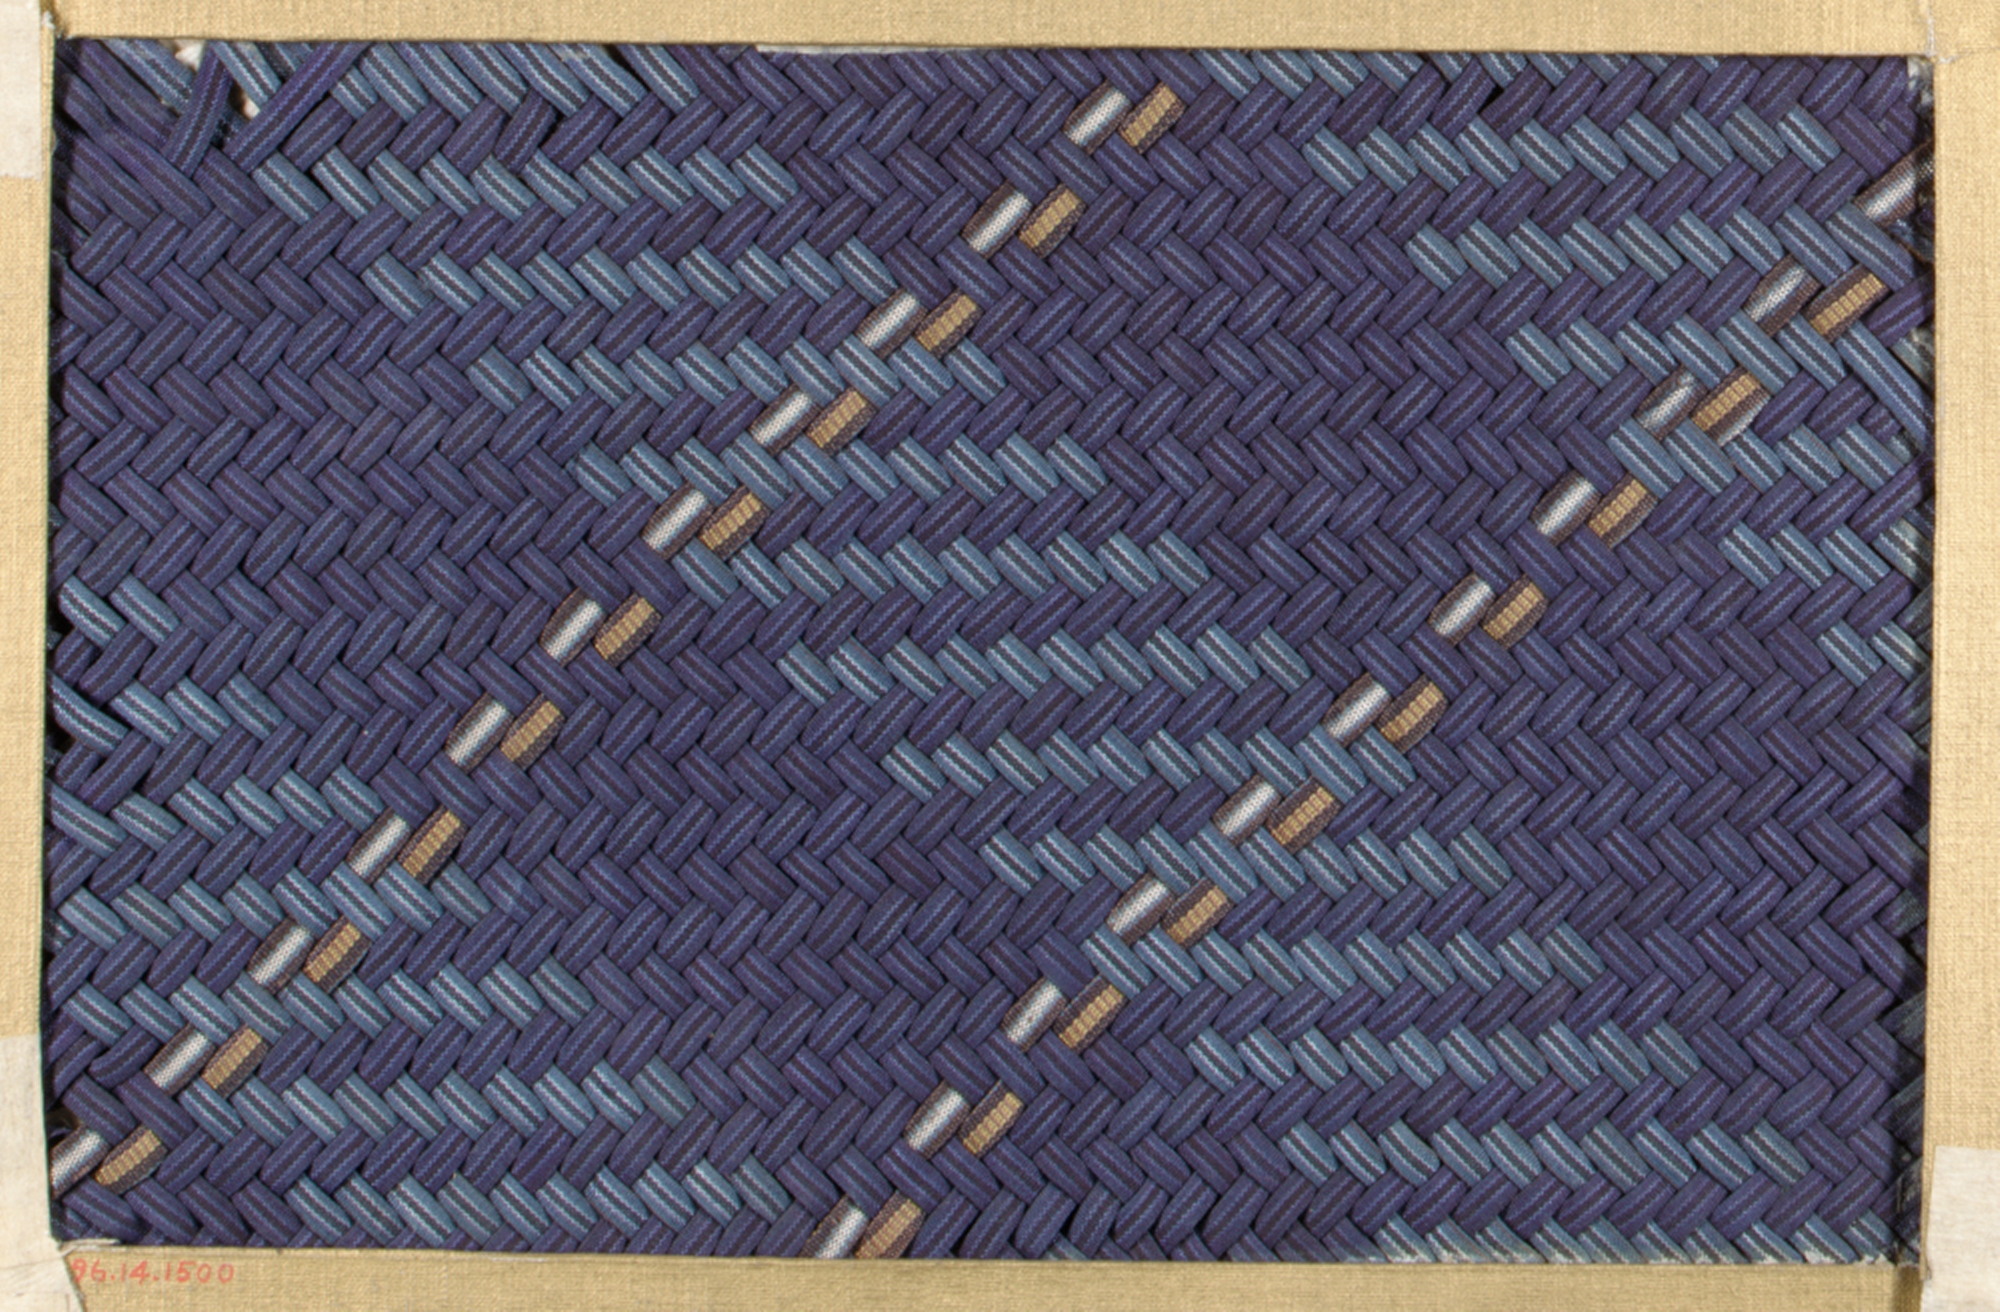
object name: piece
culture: japanese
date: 1701-1900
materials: silk